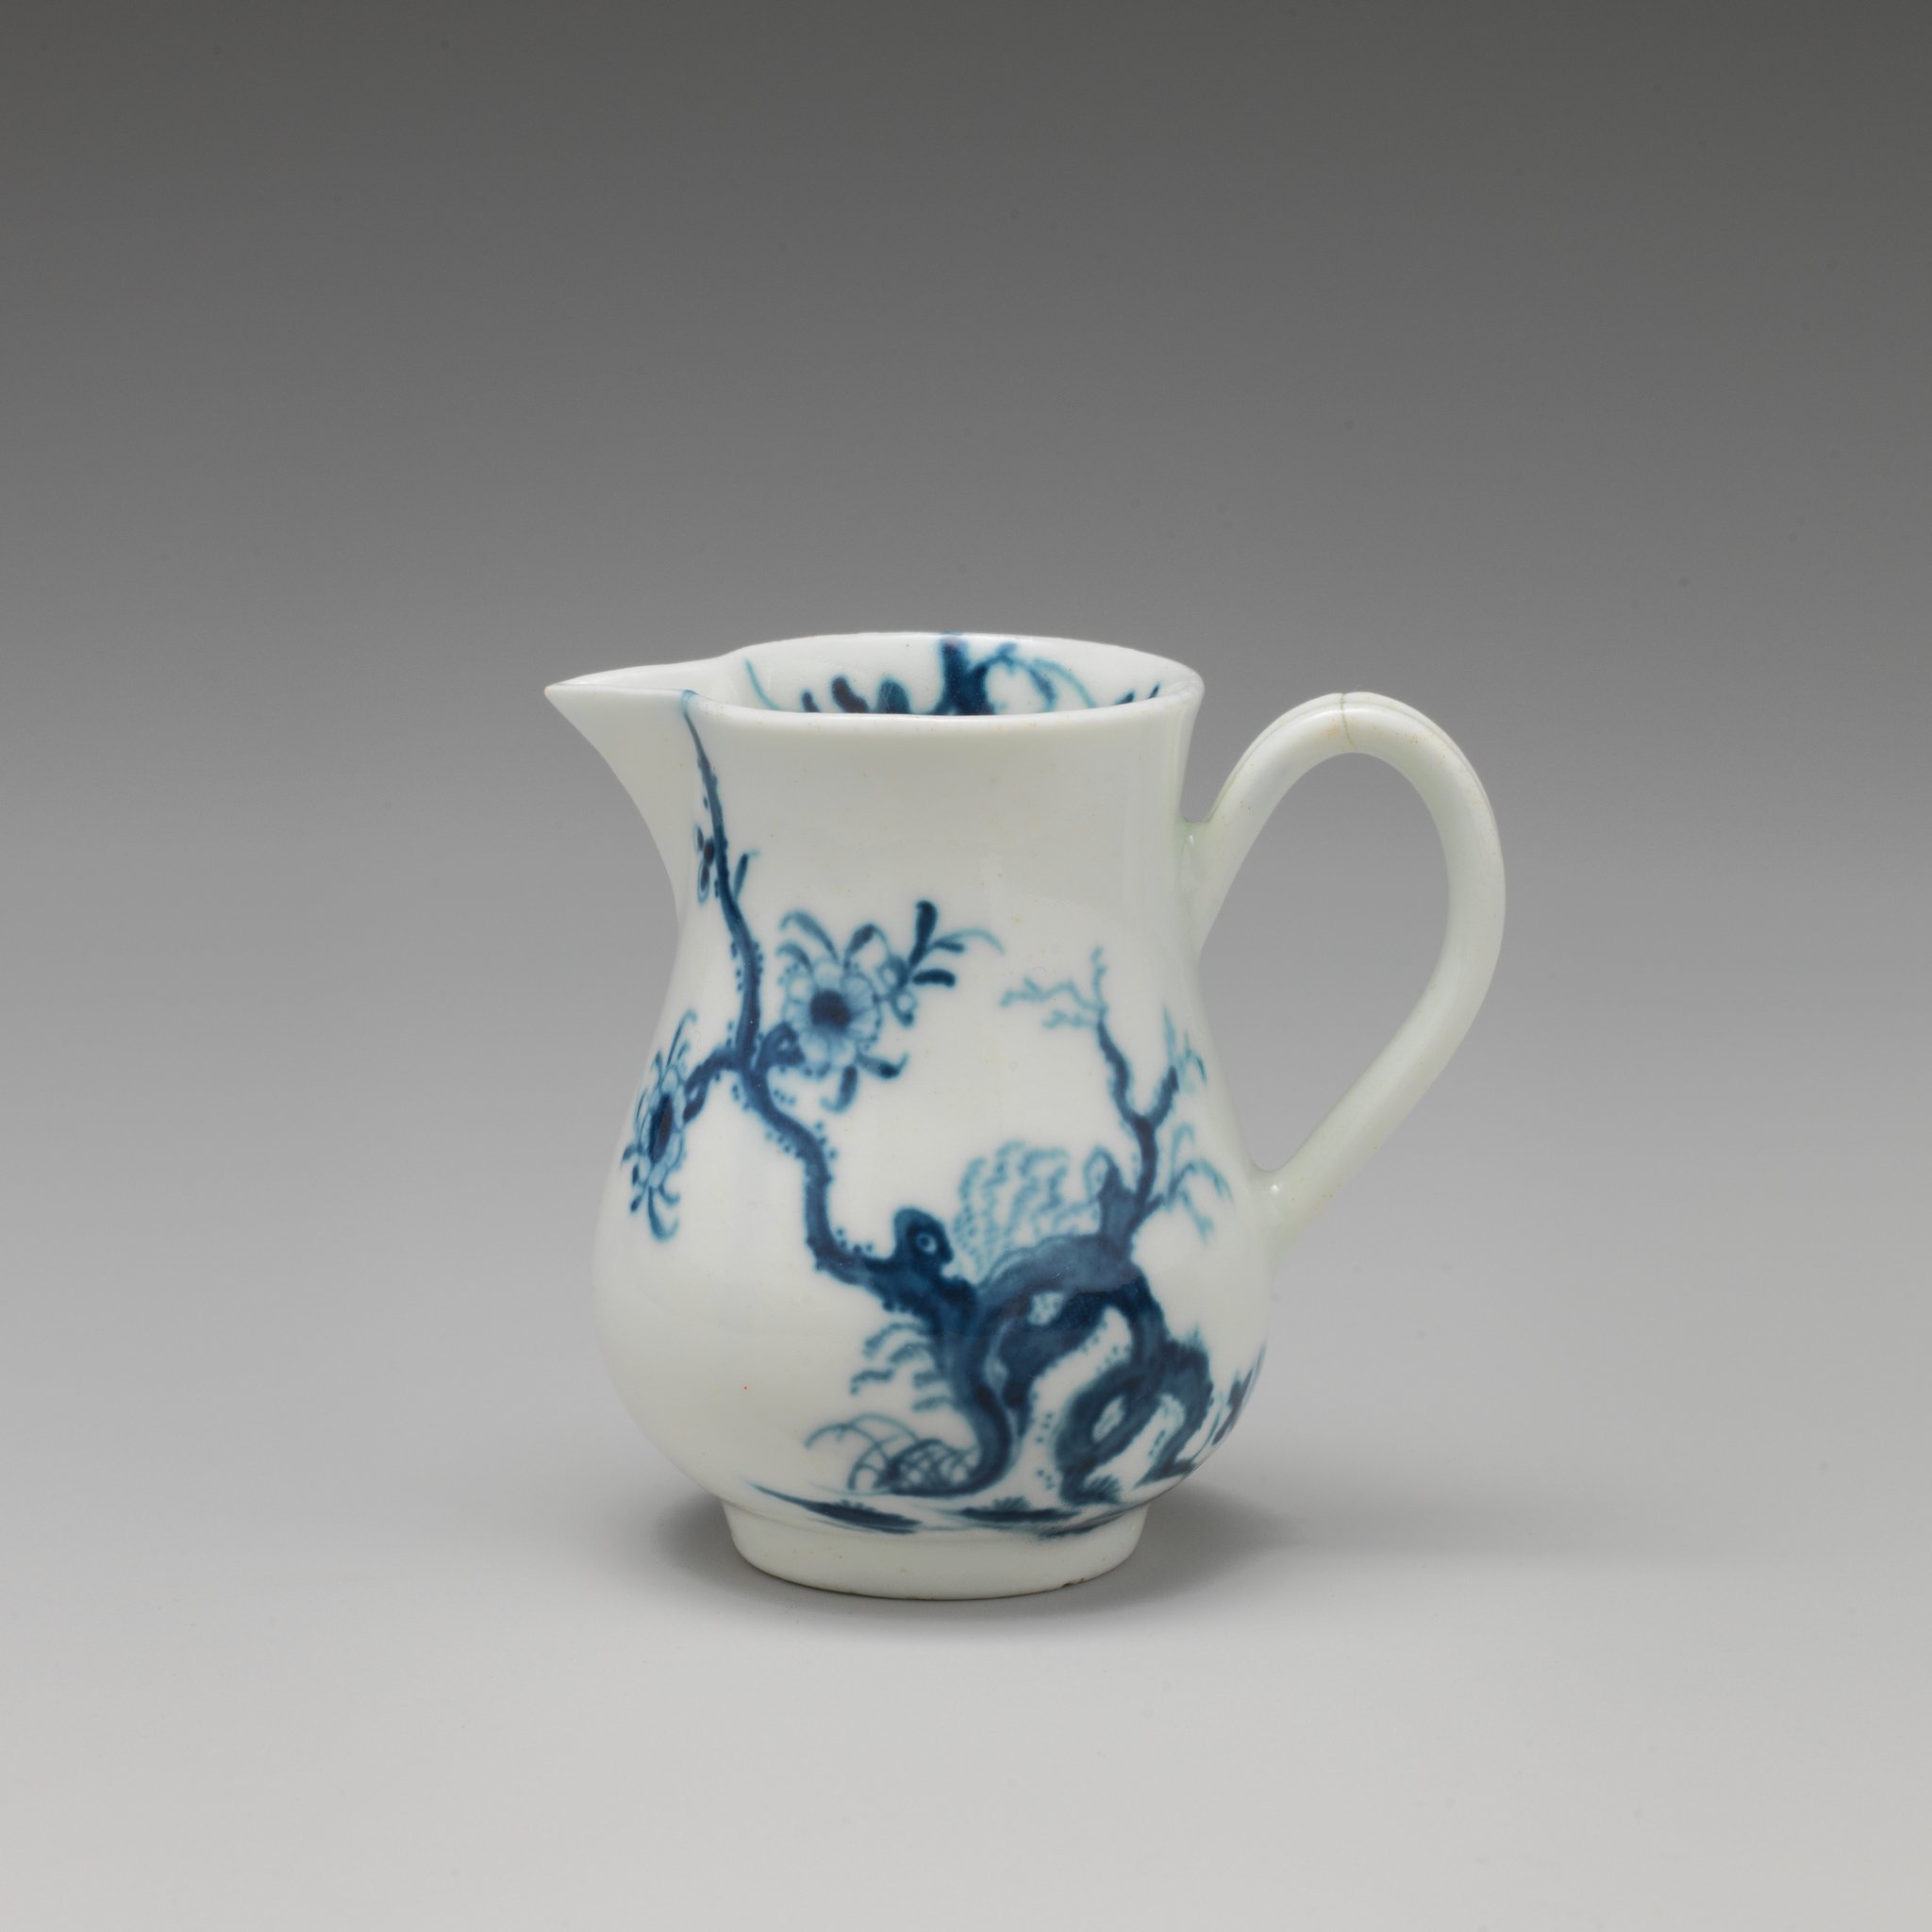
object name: pitcher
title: Miniature pitcher (part of a service)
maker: worcester factory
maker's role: factory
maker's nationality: british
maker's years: 1751-2008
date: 1760-1762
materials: soft paste porcelain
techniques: underglaze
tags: flowers